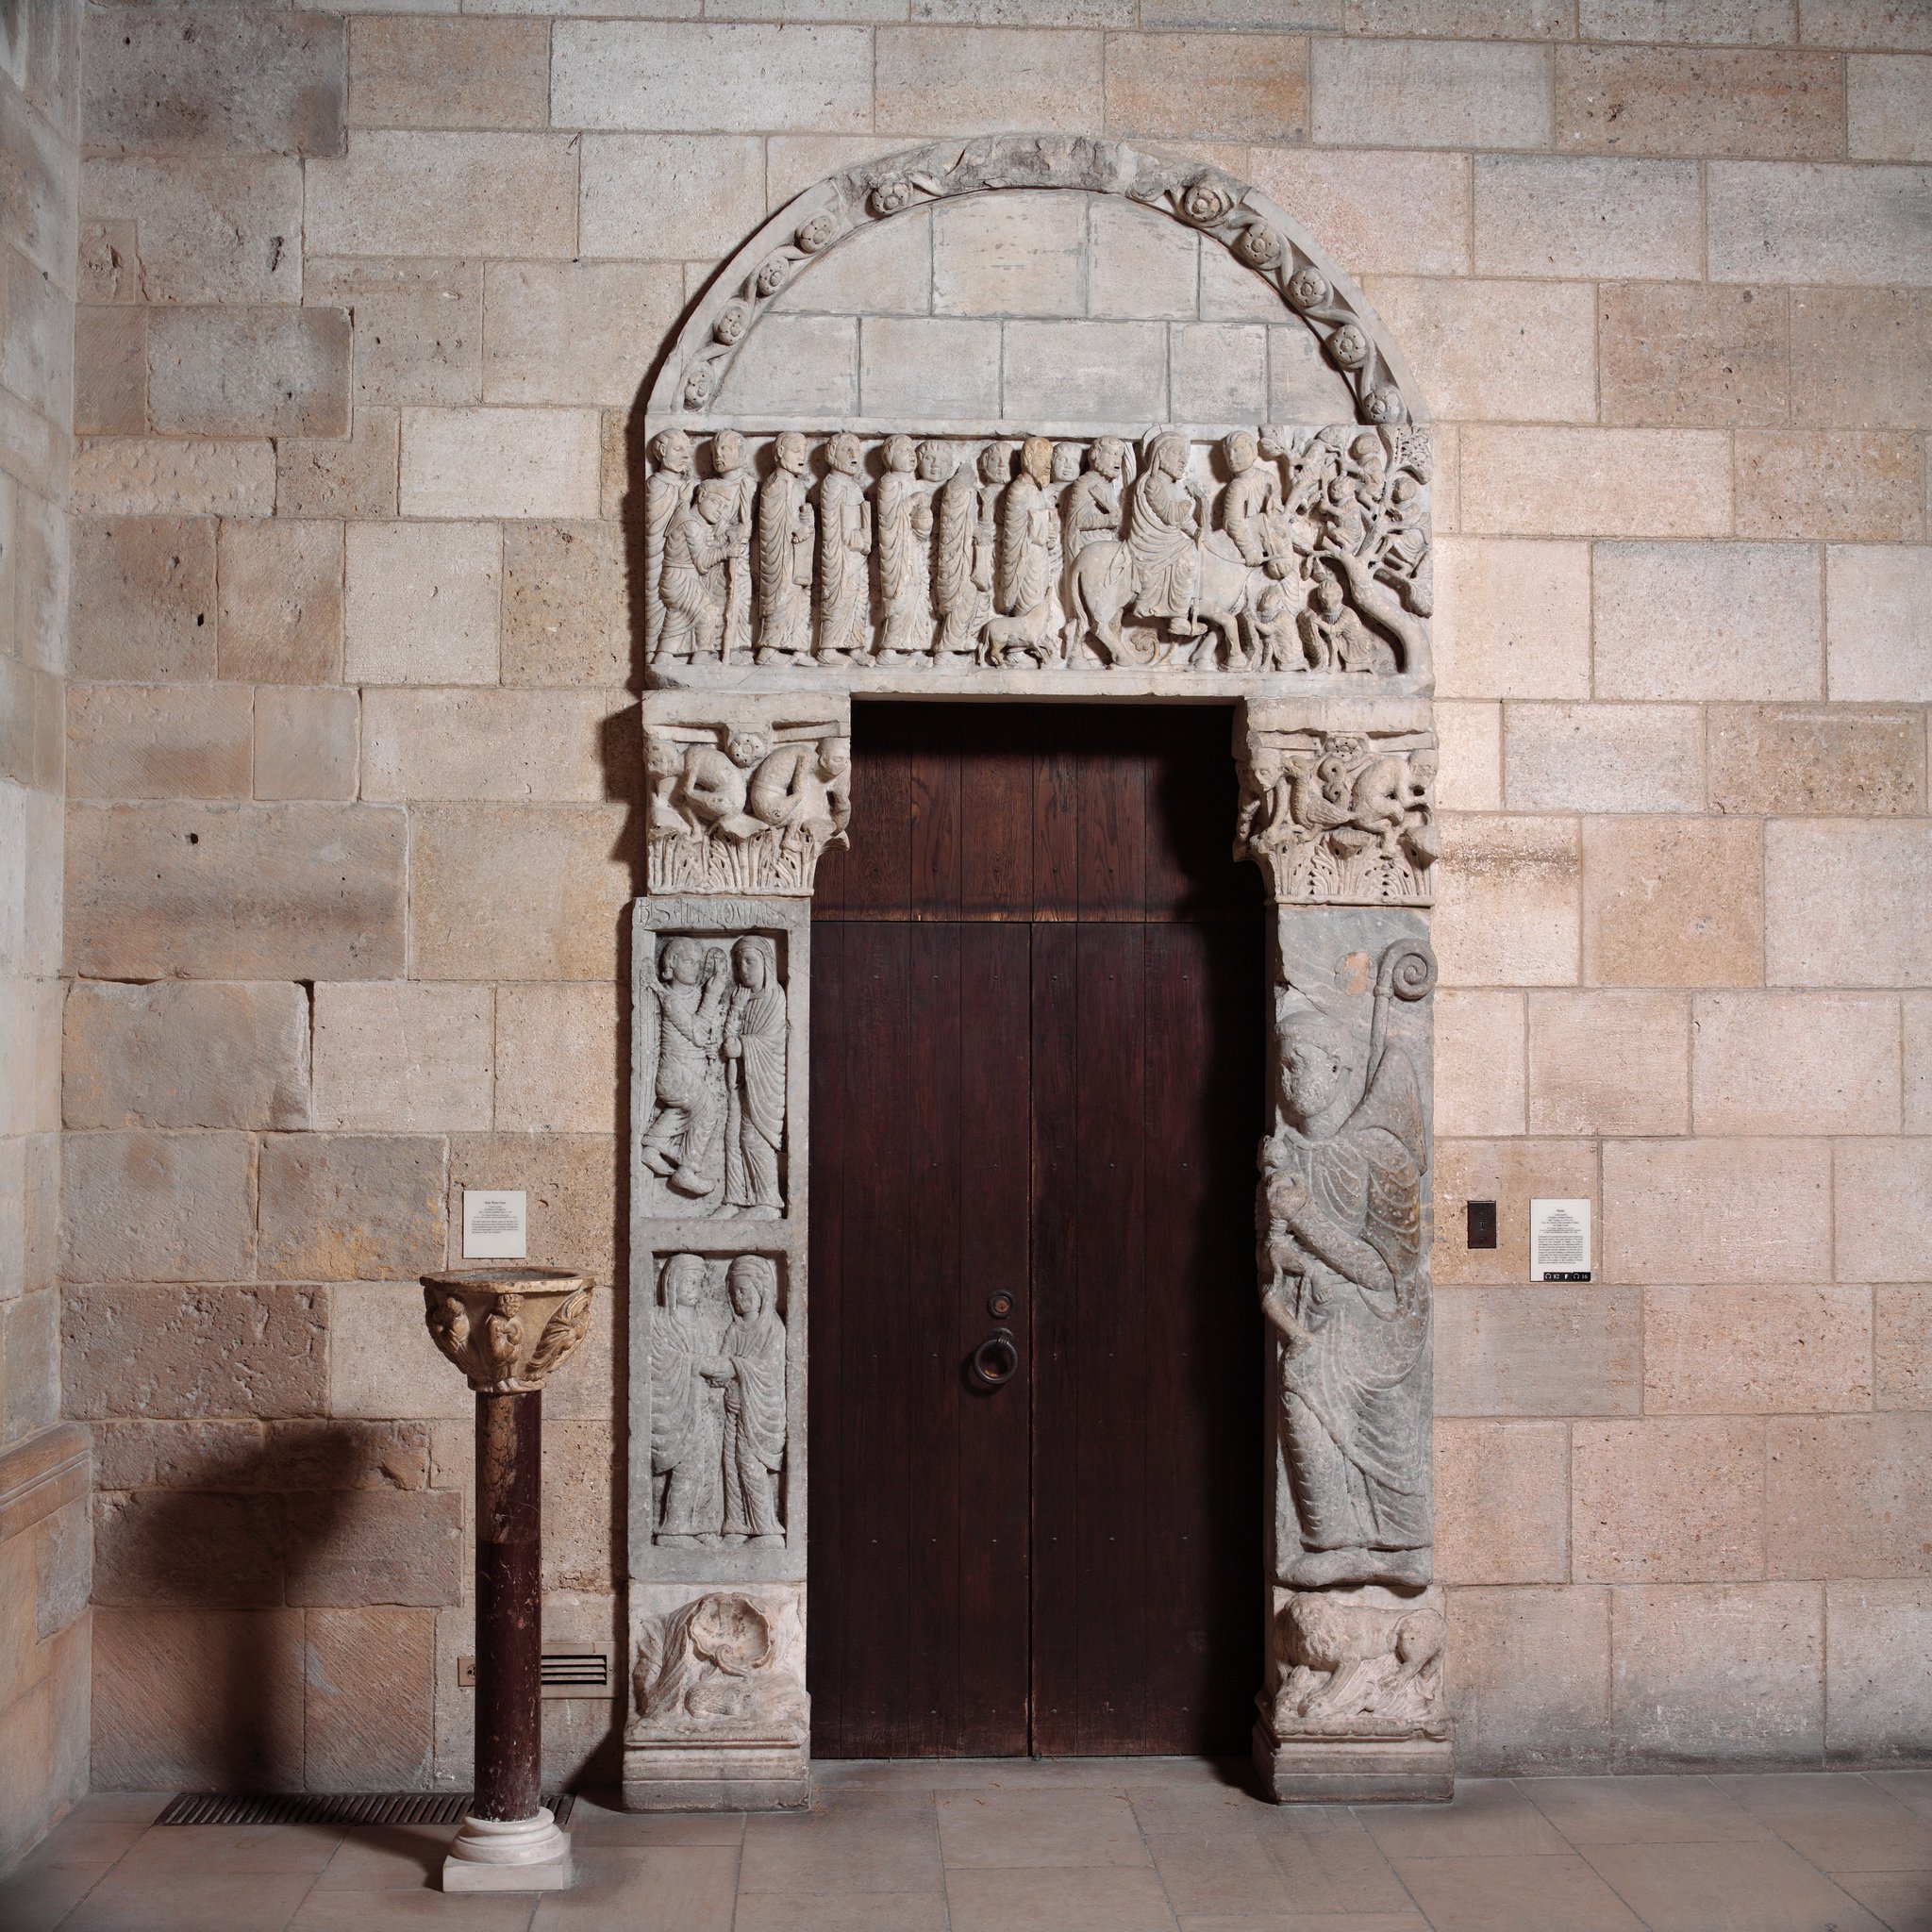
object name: portal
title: Portal from the Church of San Leonardo al Frigido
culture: italian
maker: biduinus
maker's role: artist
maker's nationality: italian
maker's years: 1175-1200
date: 1175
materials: marble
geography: italy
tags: donkeys,lions,apostles,jesus,annunciation,visitation